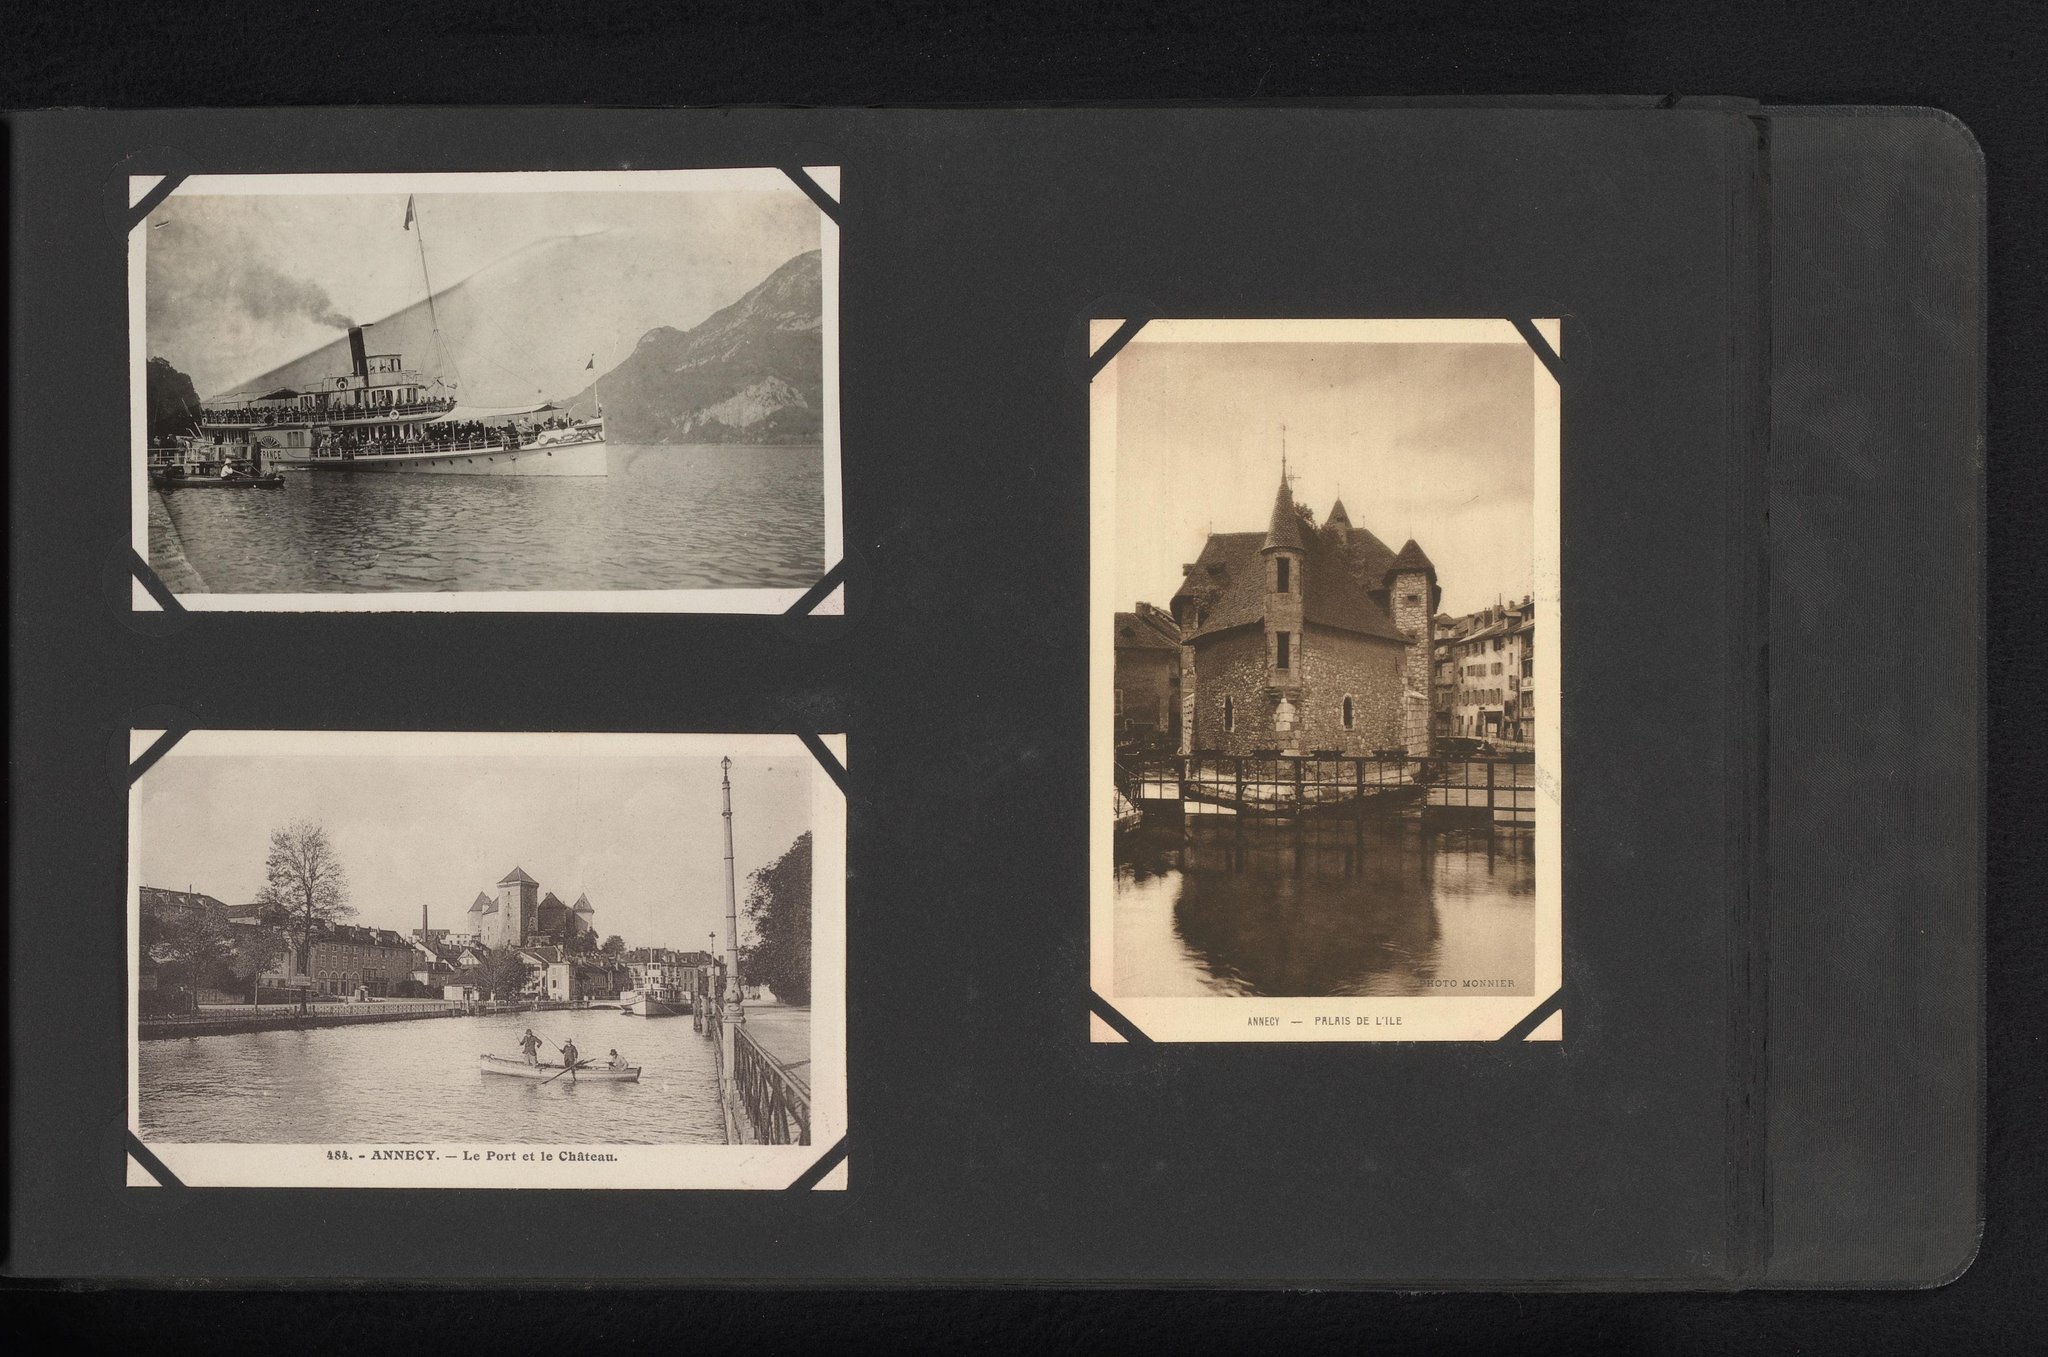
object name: album leaf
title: Twee fotomechanische prentbriefkaarten en een foto van Annecy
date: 1908-1929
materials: paper, cardboard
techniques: photograph, gelatin silver print, rotogravure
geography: annecy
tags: castle, steamship, motorship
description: Deze foto en prenten maken deel uit van een album.